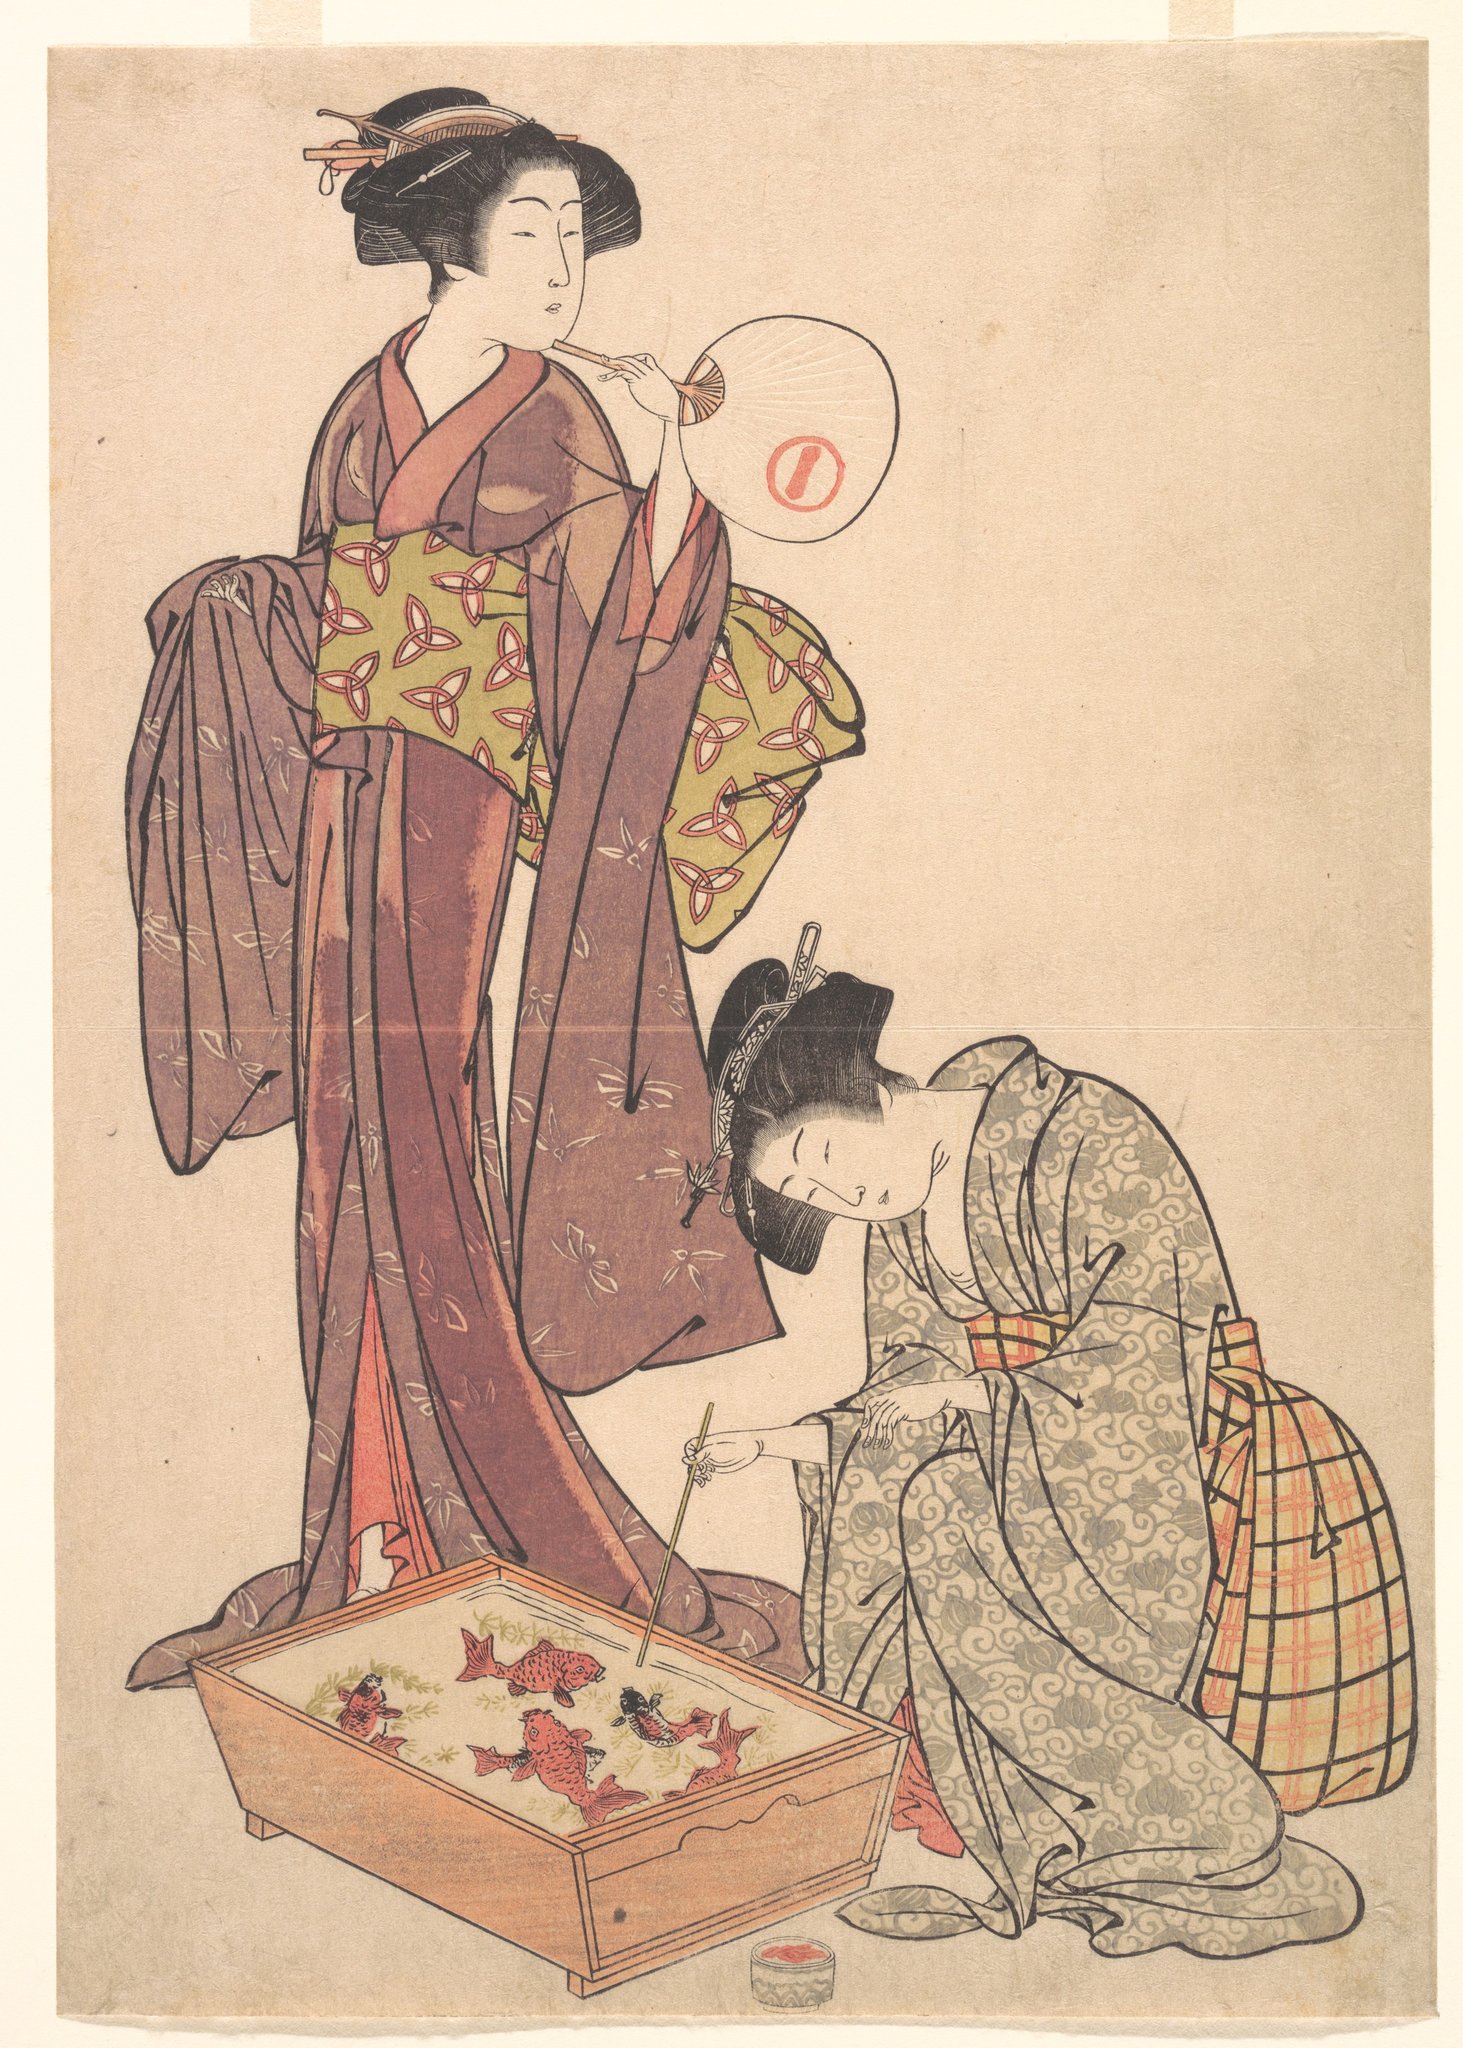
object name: woodblock print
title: Two Women Feeding Fish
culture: japanese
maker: kitao shigemasa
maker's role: artist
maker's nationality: japanese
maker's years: 1739-1820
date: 1739-1820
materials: ink, paper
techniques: woodblock print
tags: women,fish